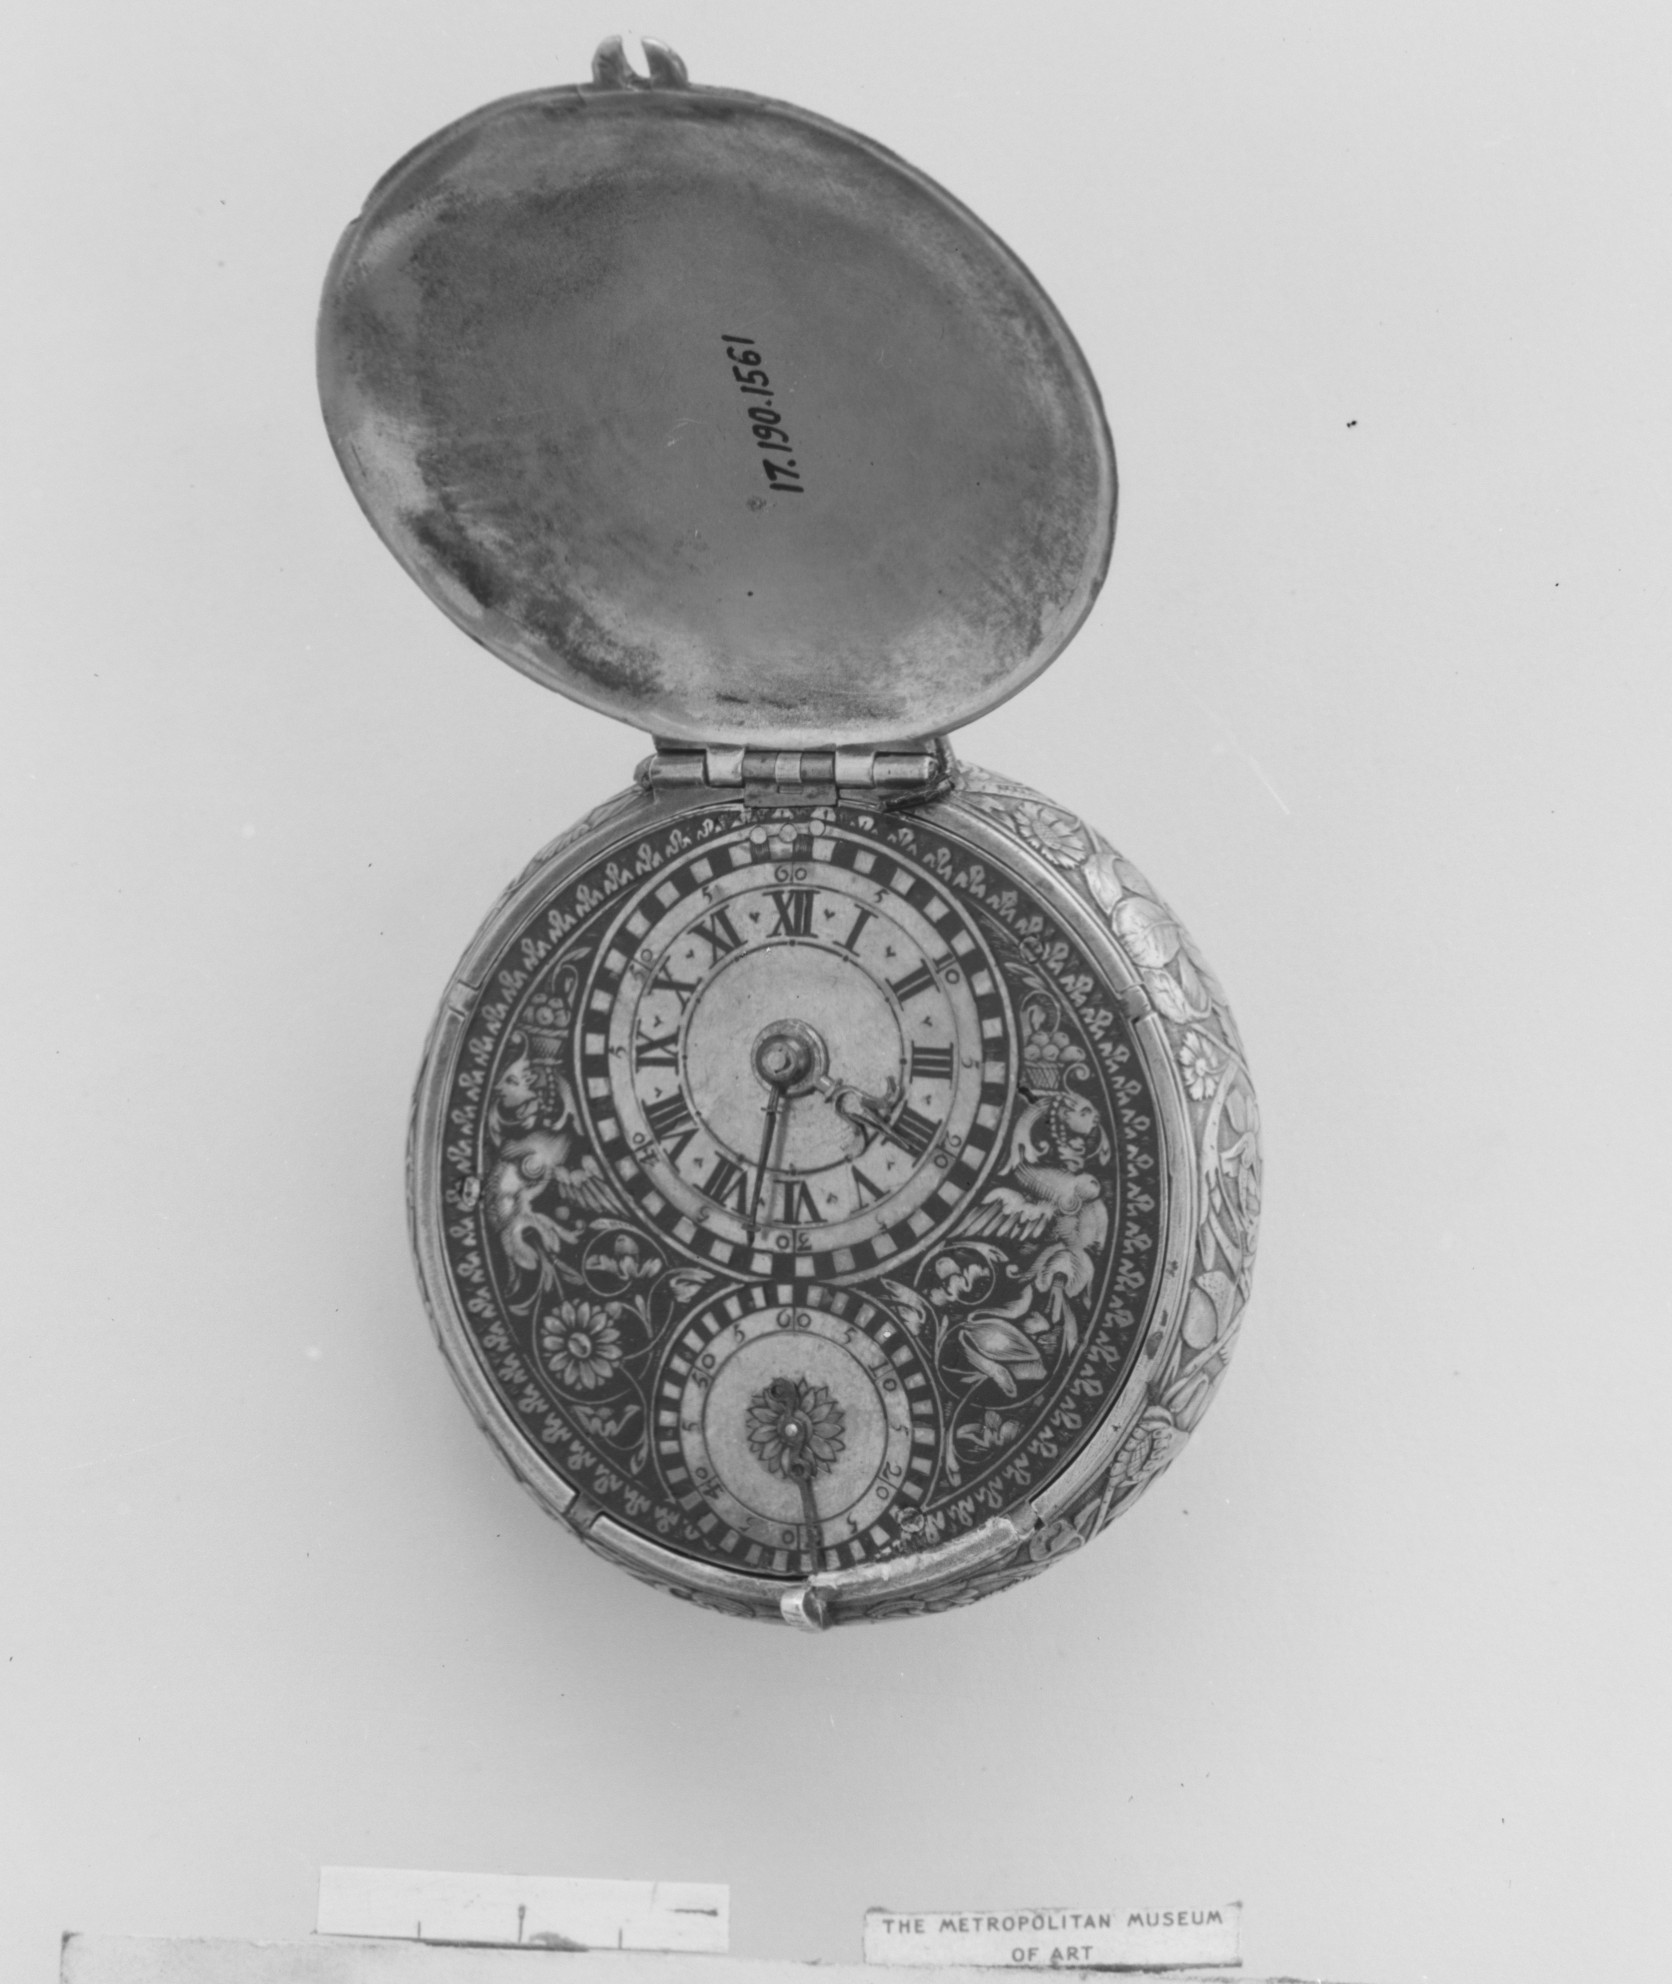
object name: watch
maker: pierre derssigny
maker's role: maker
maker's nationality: french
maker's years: 1646-1746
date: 1680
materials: silver